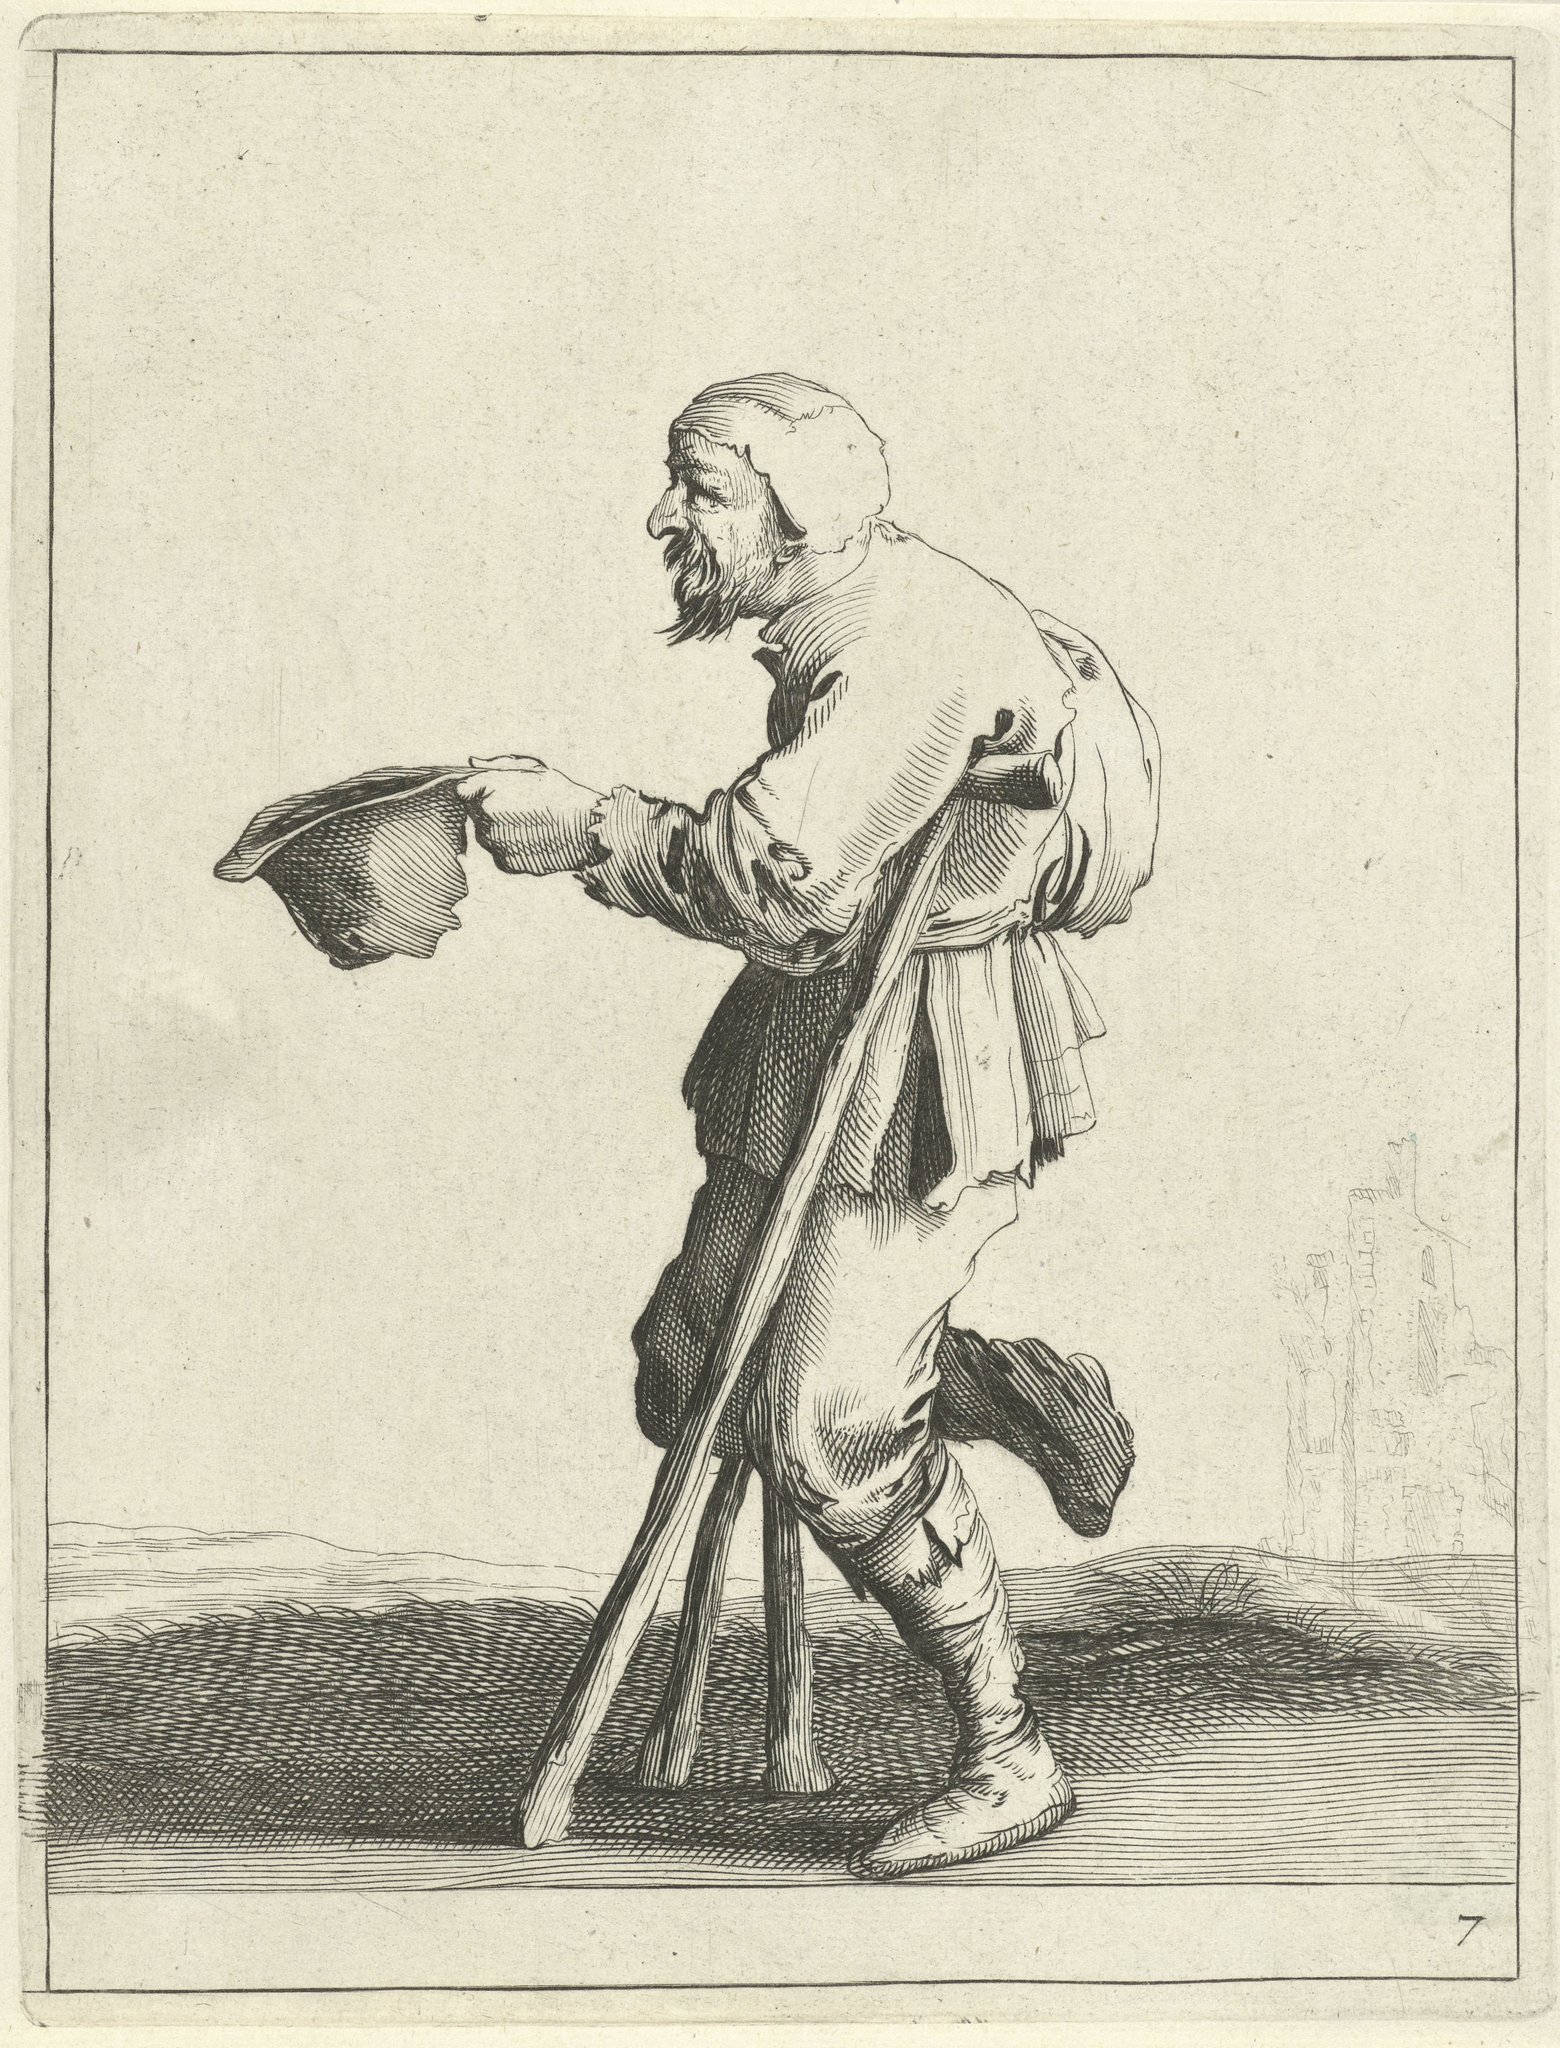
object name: print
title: Bedelaar op krukken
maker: pieter jansz quast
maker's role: draughtsman, painter, print maker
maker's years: 1605-1647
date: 1634-1638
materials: paper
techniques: engraving, etching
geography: the hague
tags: crutches, person with a physical disability, beggar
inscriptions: collector's mark: Lugt 2165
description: Een bedelaar hinkt, steunend op zijn krukken, naar links. Met zijn rechterhand houdt hij zijn hoed op. De prent maakt deel uit van een serie van zesentwintig prenten met bedelaars en boeren. Sommige figuren in deze serie zijn ook aangeduid als 'kreupele', wat in de 17de eeuw een generieke term was voor mensen met lichamelijke beperkingen.